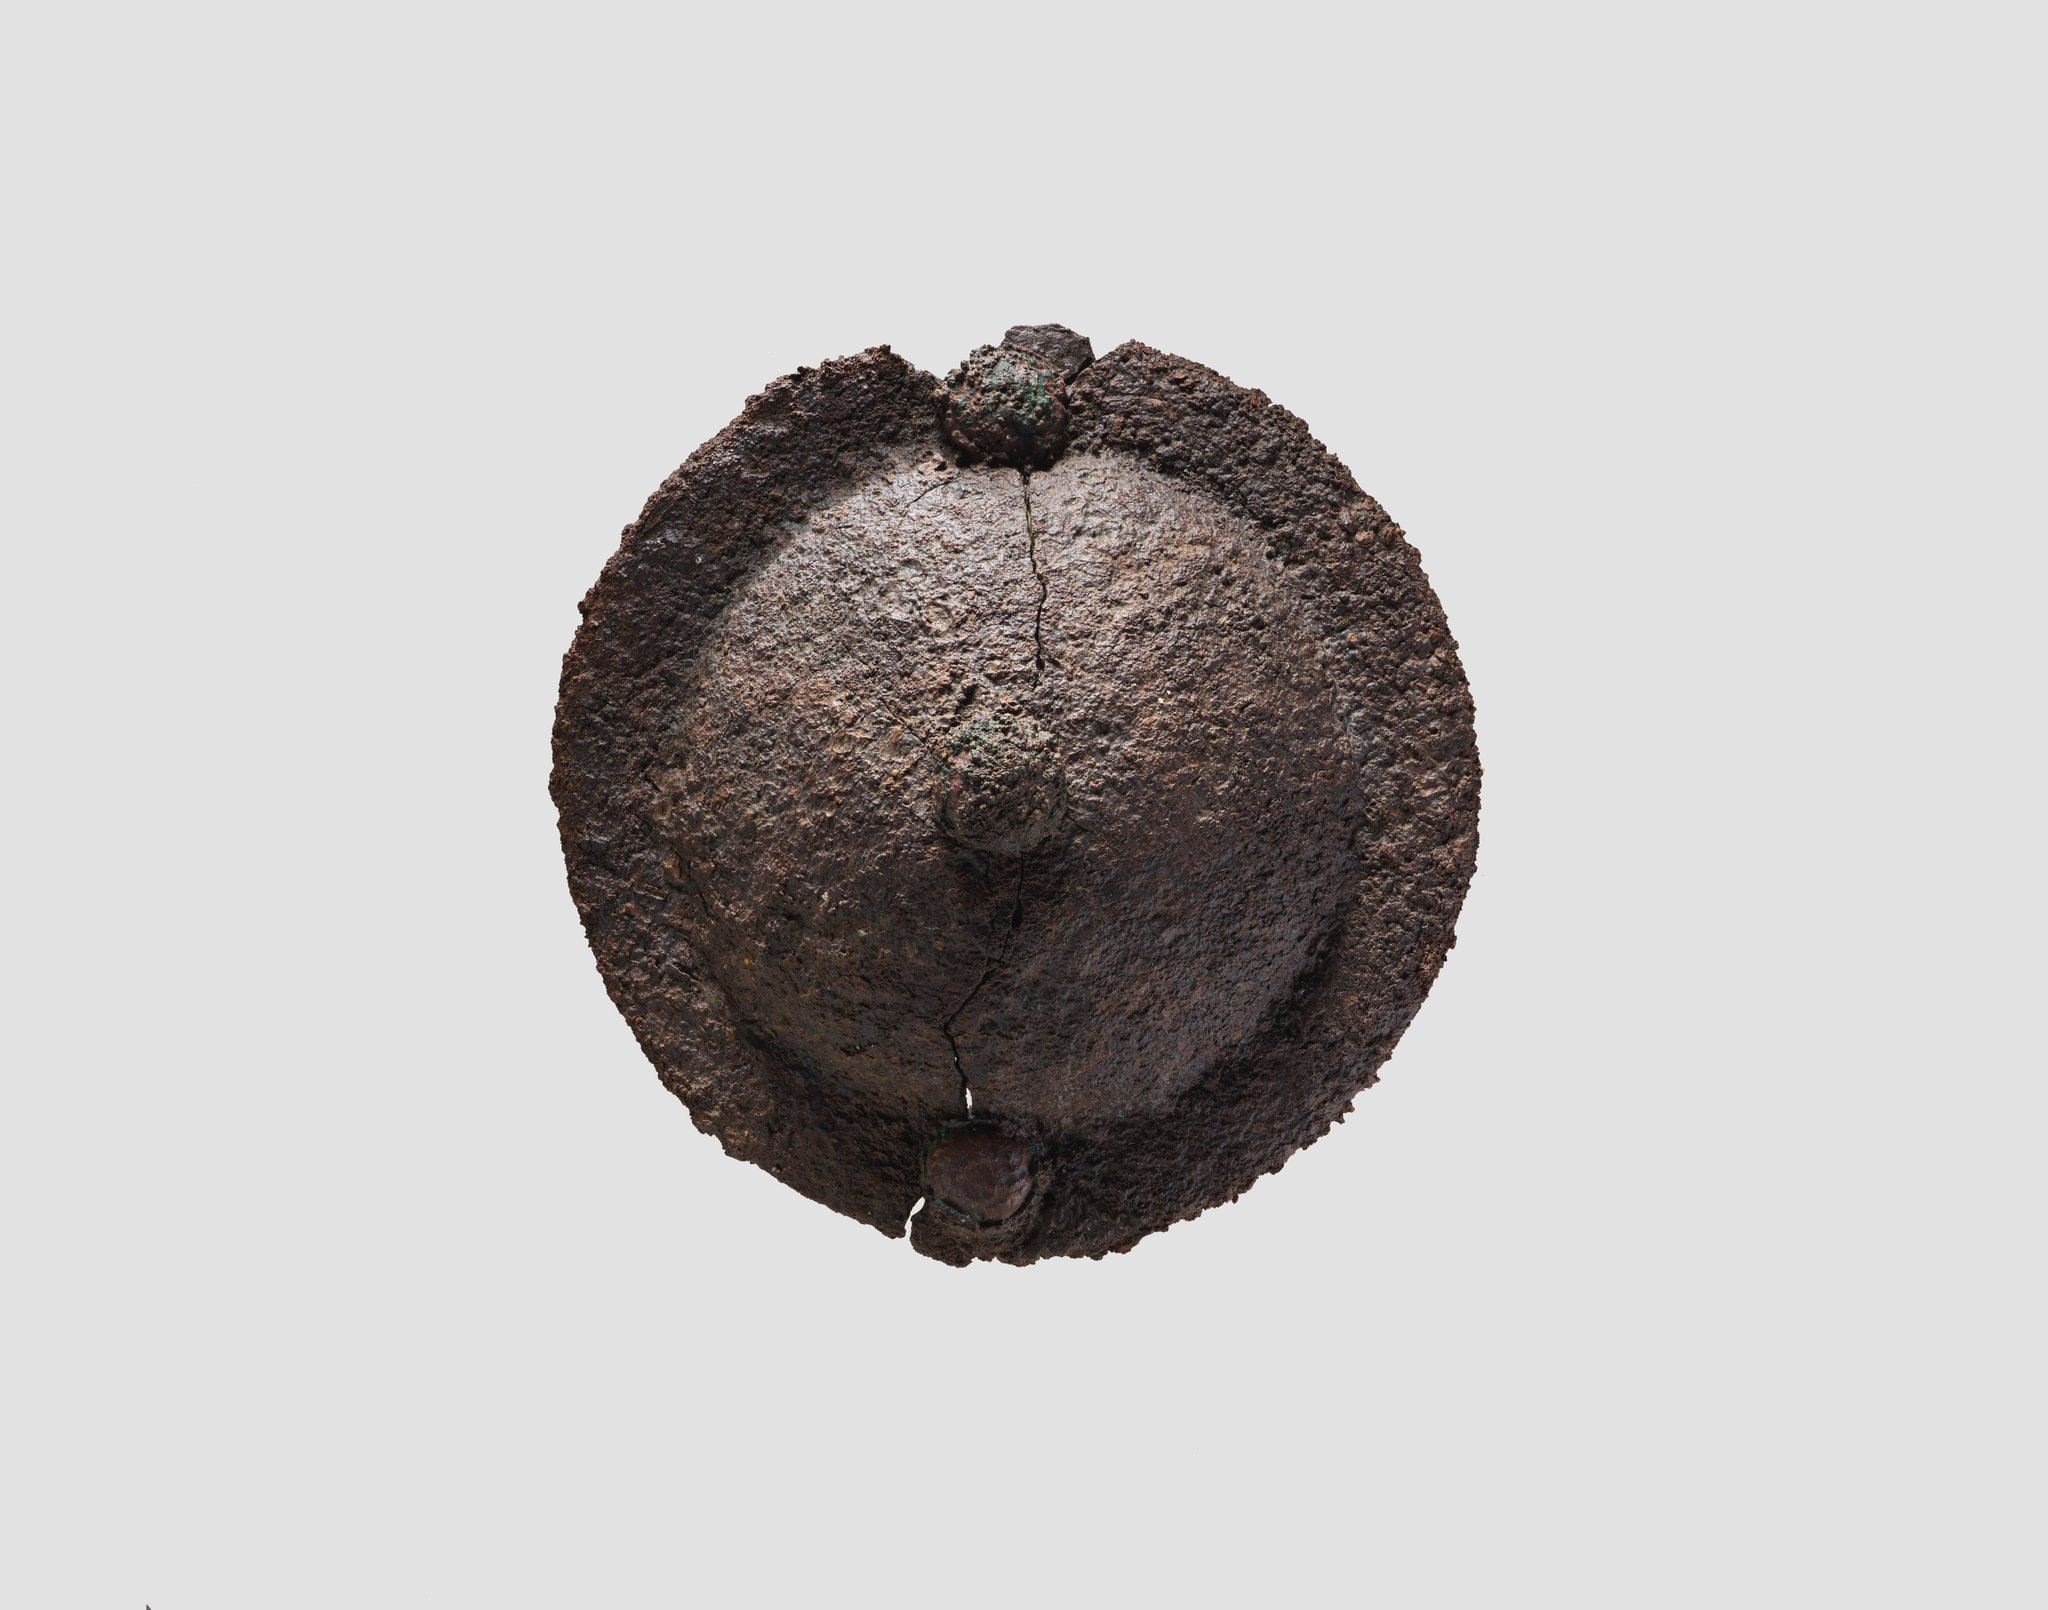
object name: umbo or stud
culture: iranian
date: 900-801 BCE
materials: bronze, iron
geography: iran